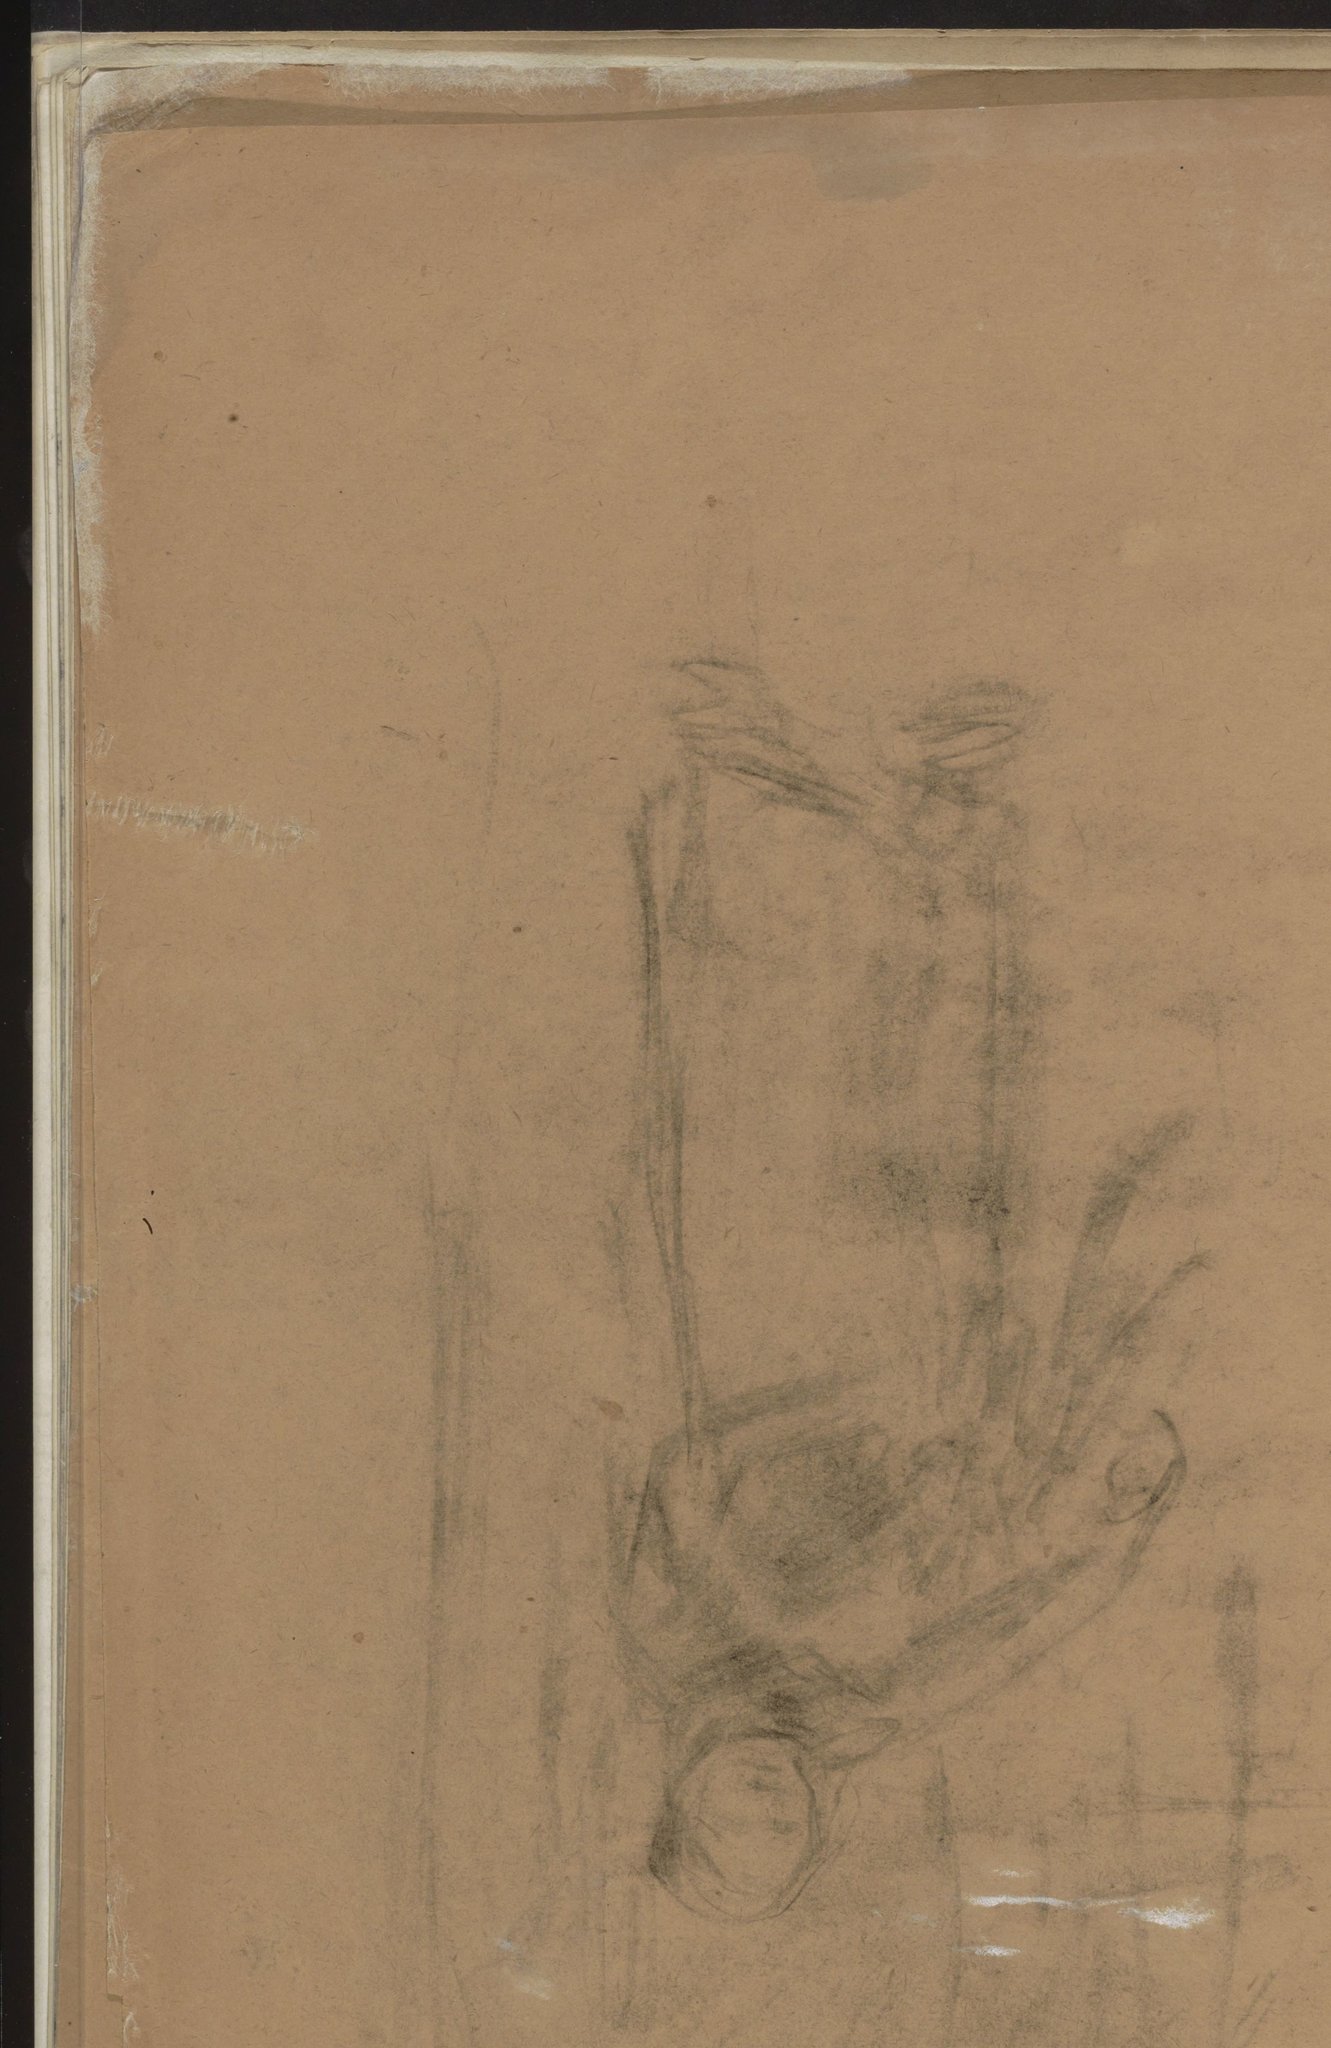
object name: sketchbook leaf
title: Jonge vrouw in een bos met sprokkelhout onder de arm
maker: albert neuhuys (1844-1914)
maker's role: draughtsman, painter, print maker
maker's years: 1844-1914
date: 1854-1914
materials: charcoal, paint, paper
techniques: brush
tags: carrying something, farmers, girl (child between toddler and youth), forest, wood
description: Blad 52 verso uit een schetsboek met 53 bladen.